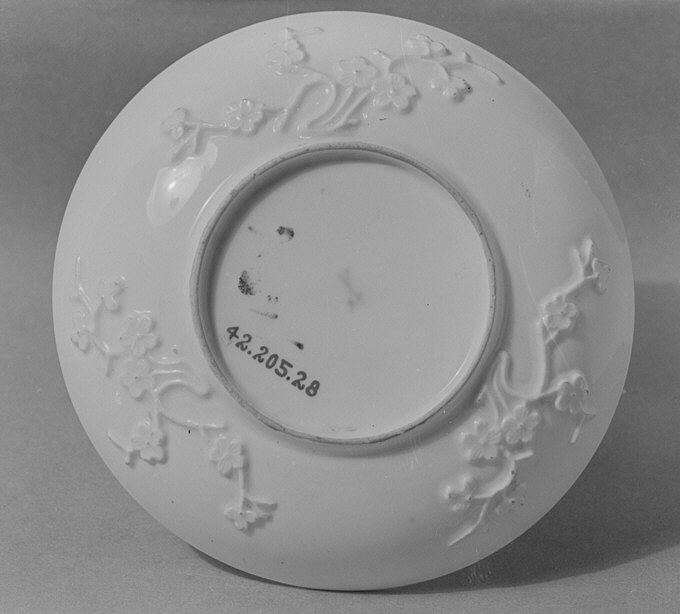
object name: saucer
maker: meissen manufactory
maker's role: manufactory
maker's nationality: german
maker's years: 1710-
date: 1740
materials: hard paste porcelain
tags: flowers